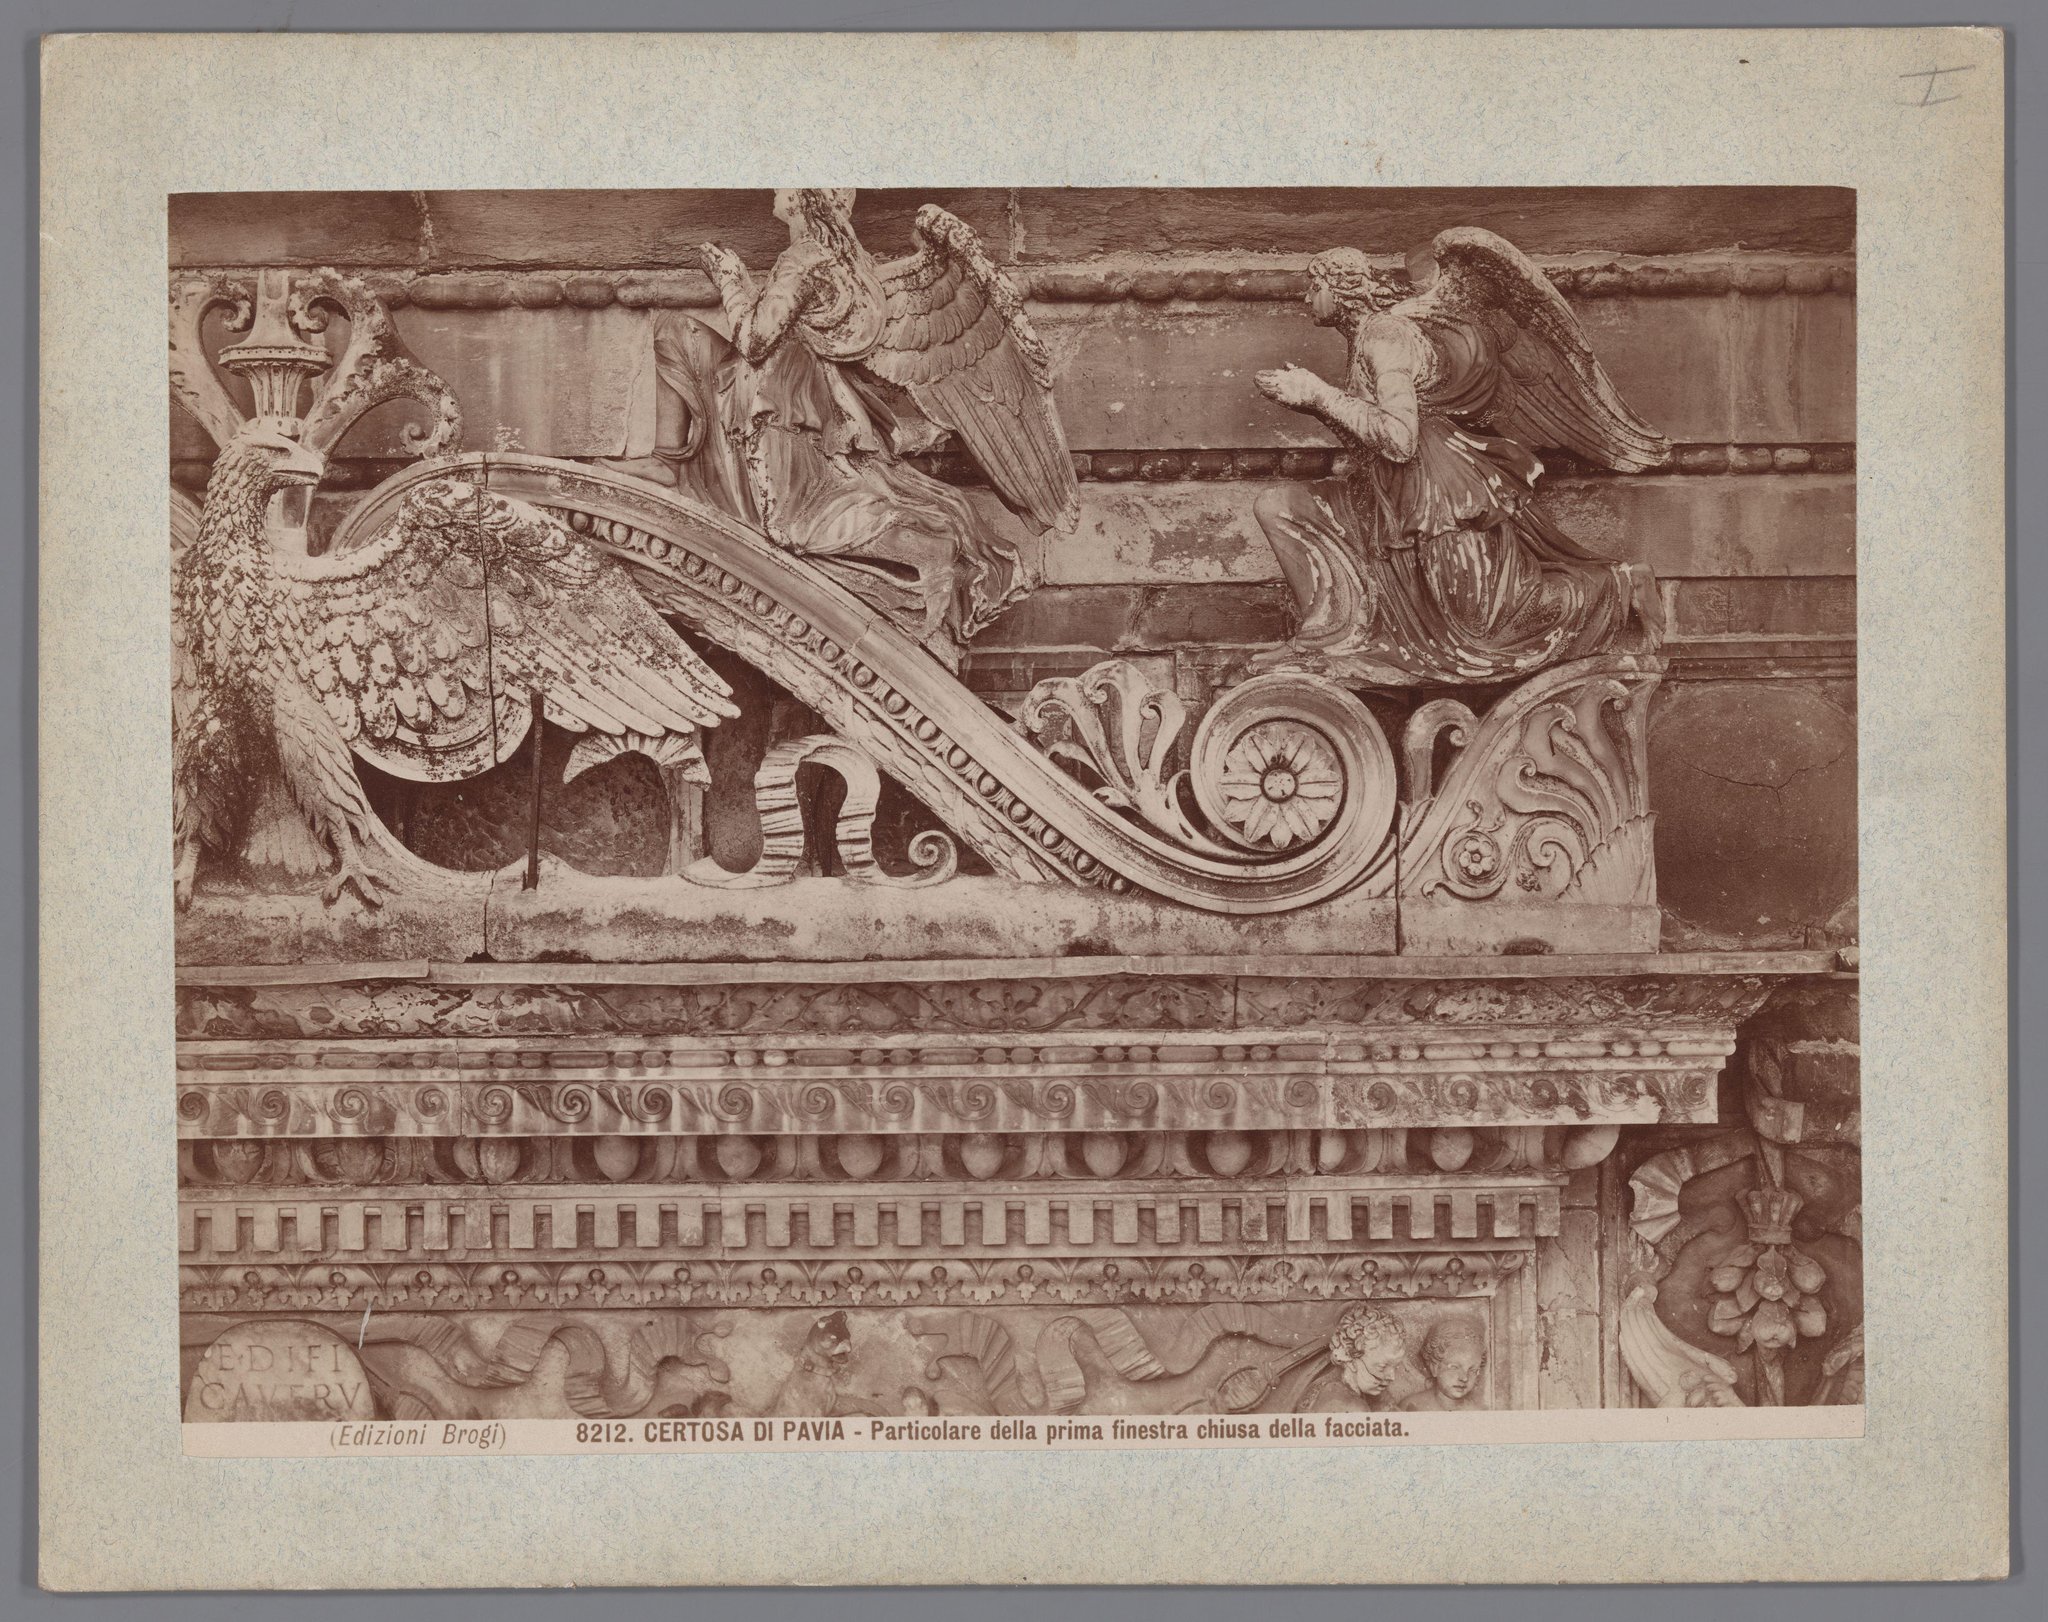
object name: photograph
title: Particolare della prima finestra chiusa della facciata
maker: Anonymous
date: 1850-1900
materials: cardboard, photographic support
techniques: albumen print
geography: lombardy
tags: decorated gable, predatory birds: eagle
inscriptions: collector's mark: Lugt 3937, number: ‘8212’, inscription: ‘Edizioni Brogi’